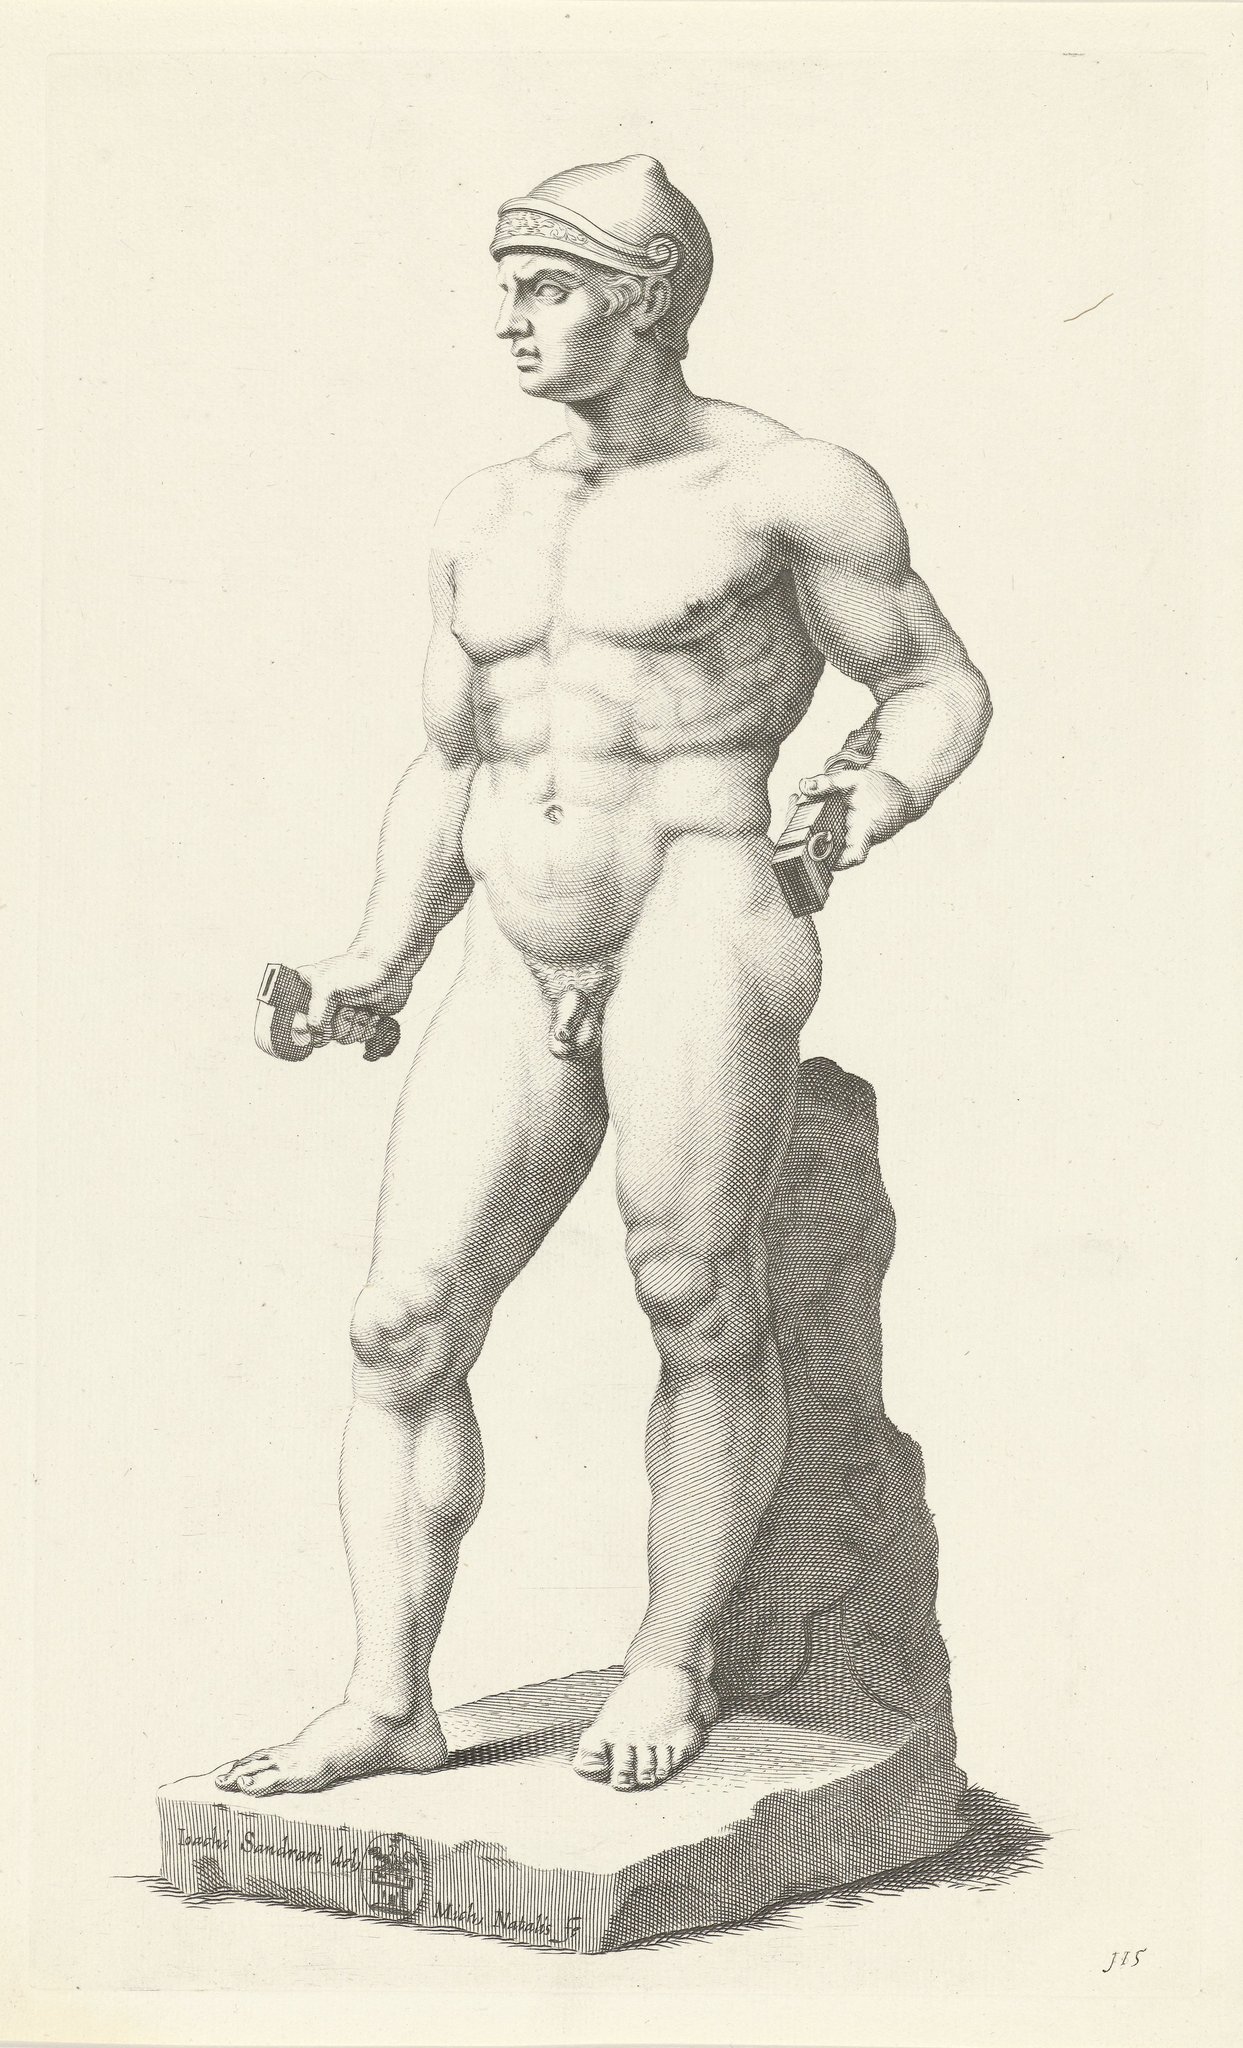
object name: print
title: Galleria Giustiniana del Marchese Vincenzo Giustiniani I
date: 1640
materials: paper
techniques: engraving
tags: rome, vincenzo giustiniani (1564-1637), helmet, fight of gladiators (+ variant), male persons from classical history (+ full length), piece of sculpture, reproduction of a piece of sculpture, monument, statue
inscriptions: collector's mark: Lugt 2228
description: Standbeeld van een gladiator met een helm op het hoofd en in beide handen een gevest van een zwaard. Midden onder op de basis het wapenschild van Vincenzo Giustiniani. Prent uit een serie naar de sculpturen in de verzameling in de Galleria Giustiniani te Rome.